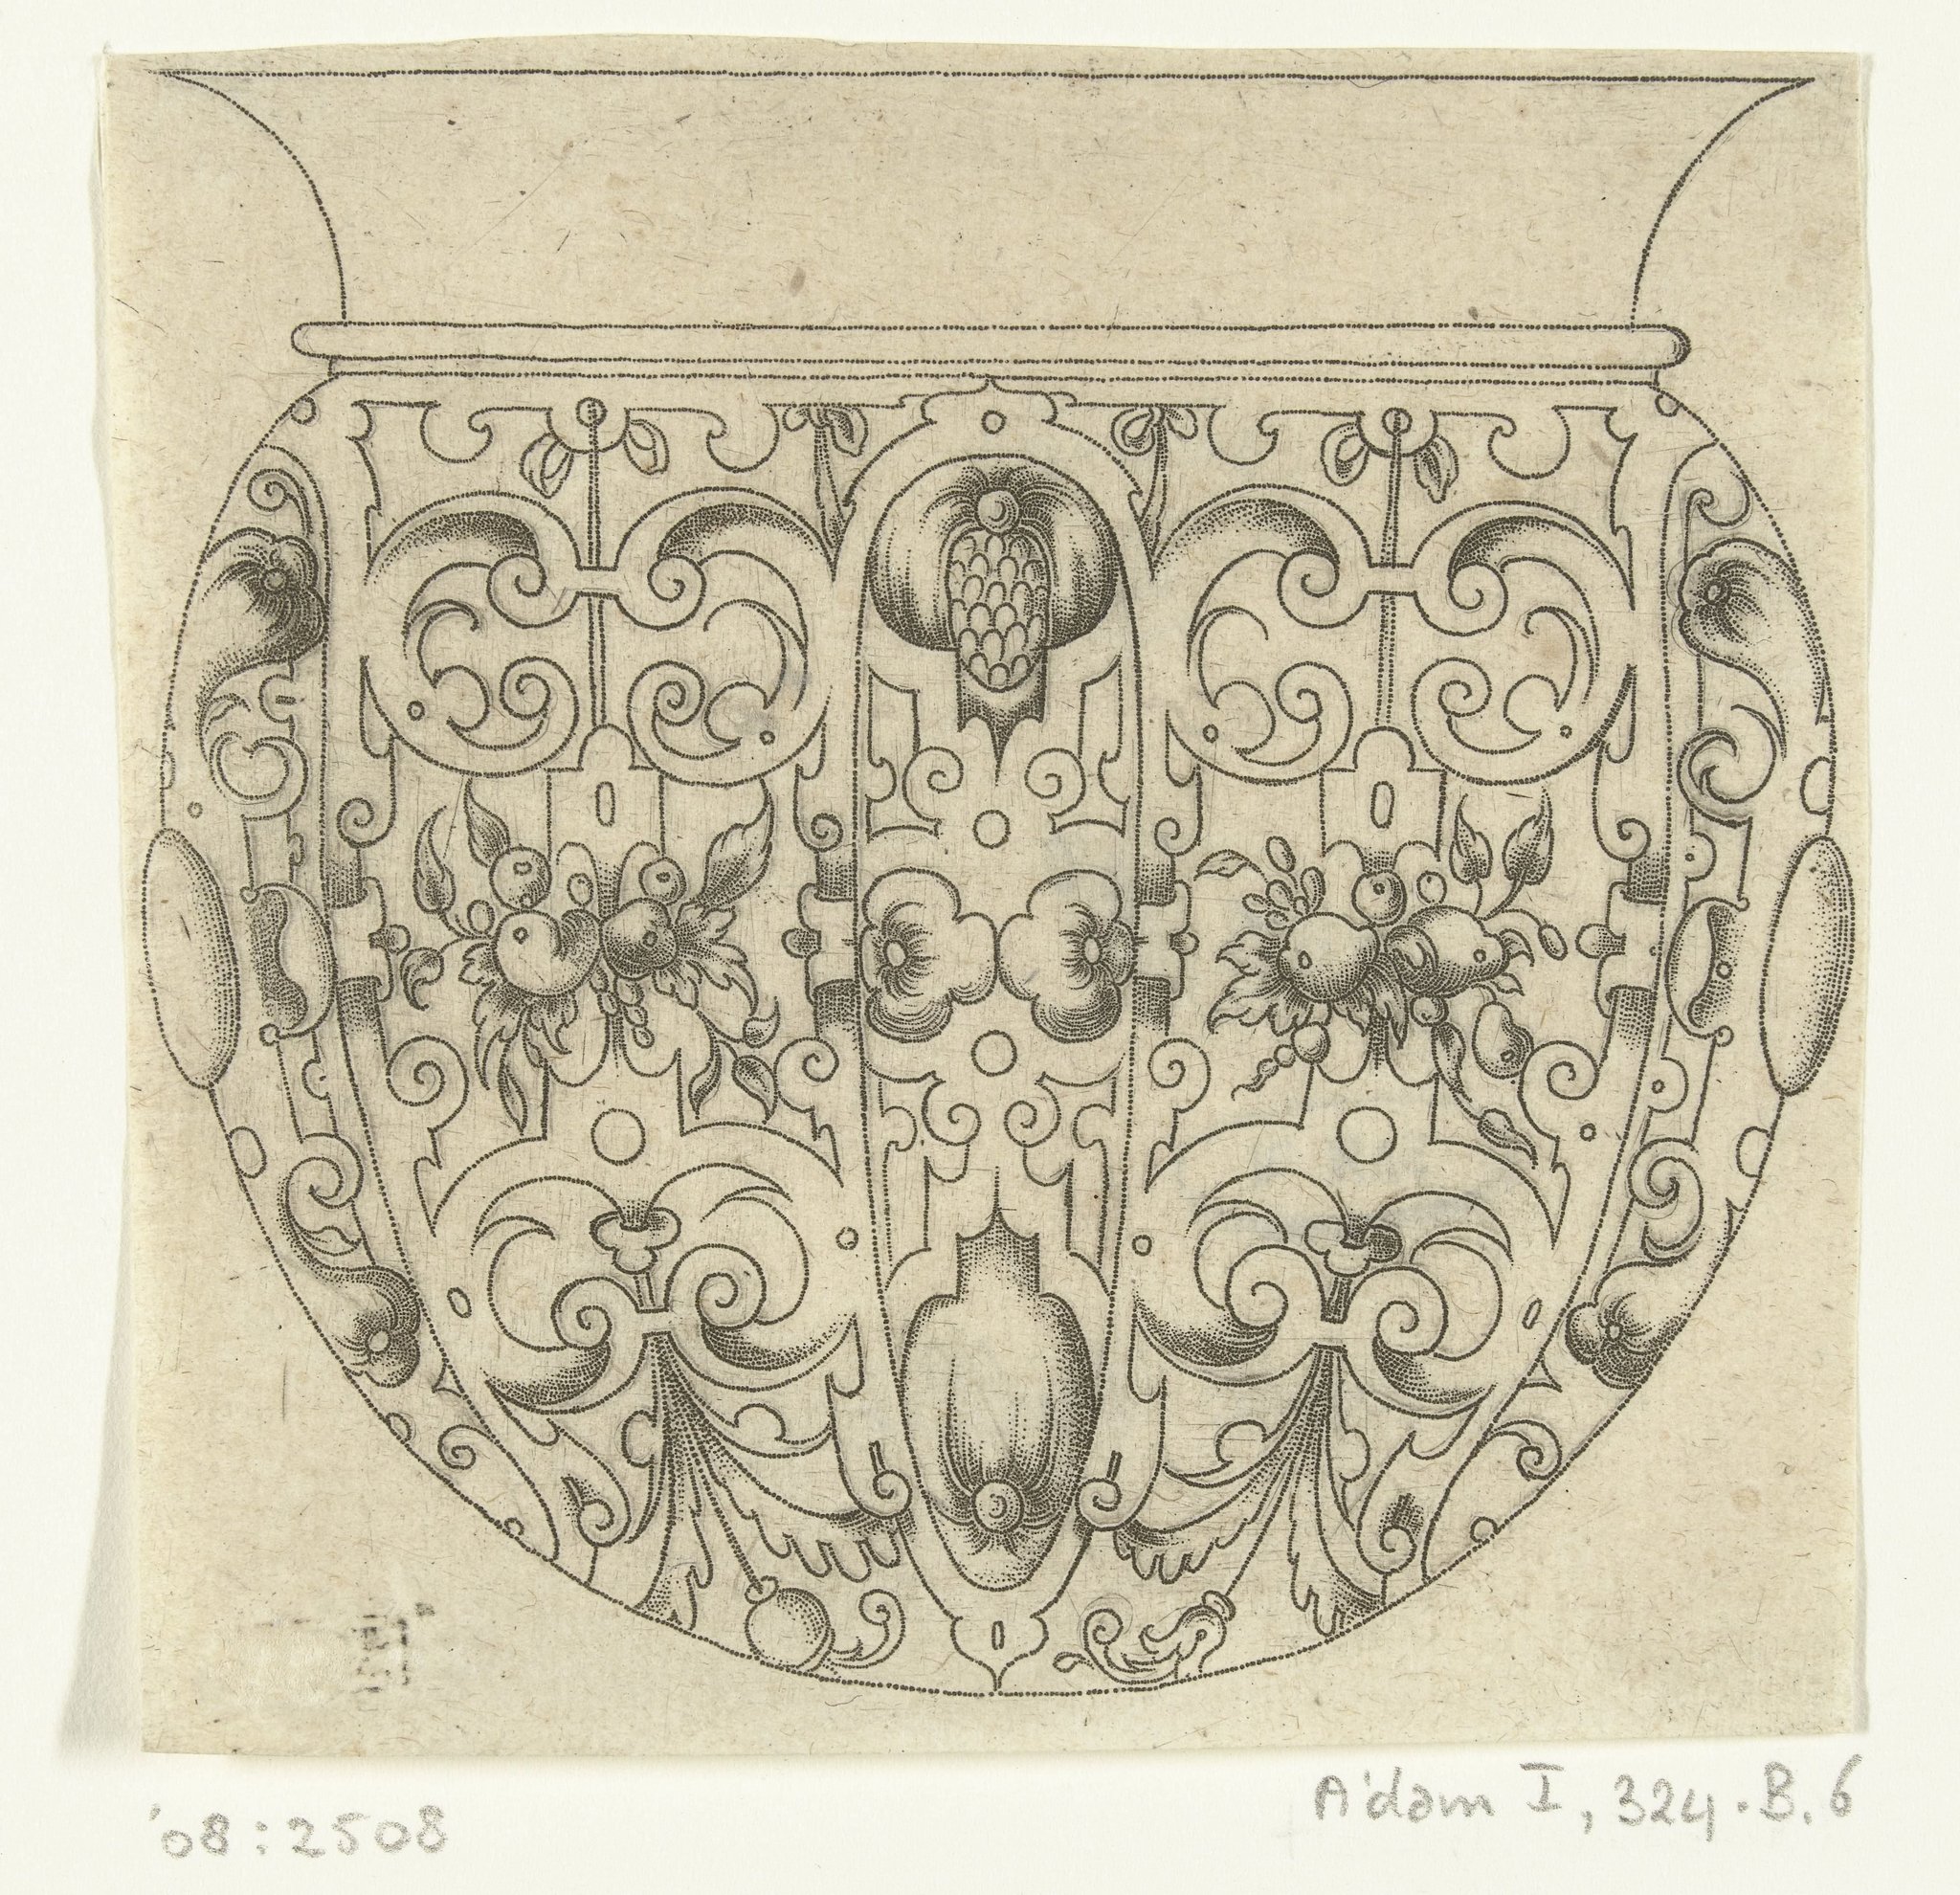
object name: ornament print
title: Bekers, bokalen en schalen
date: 1594-1635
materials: paper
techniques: engraving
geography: germany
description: Middenboven hangt een granaatappel, middenonder twee bloemen. Tegenzijdige kopieën van de onder Orn Cat I-324.A vermelde serie. Titelblad en 14 deels genummerde bladen uit een serie van 25.